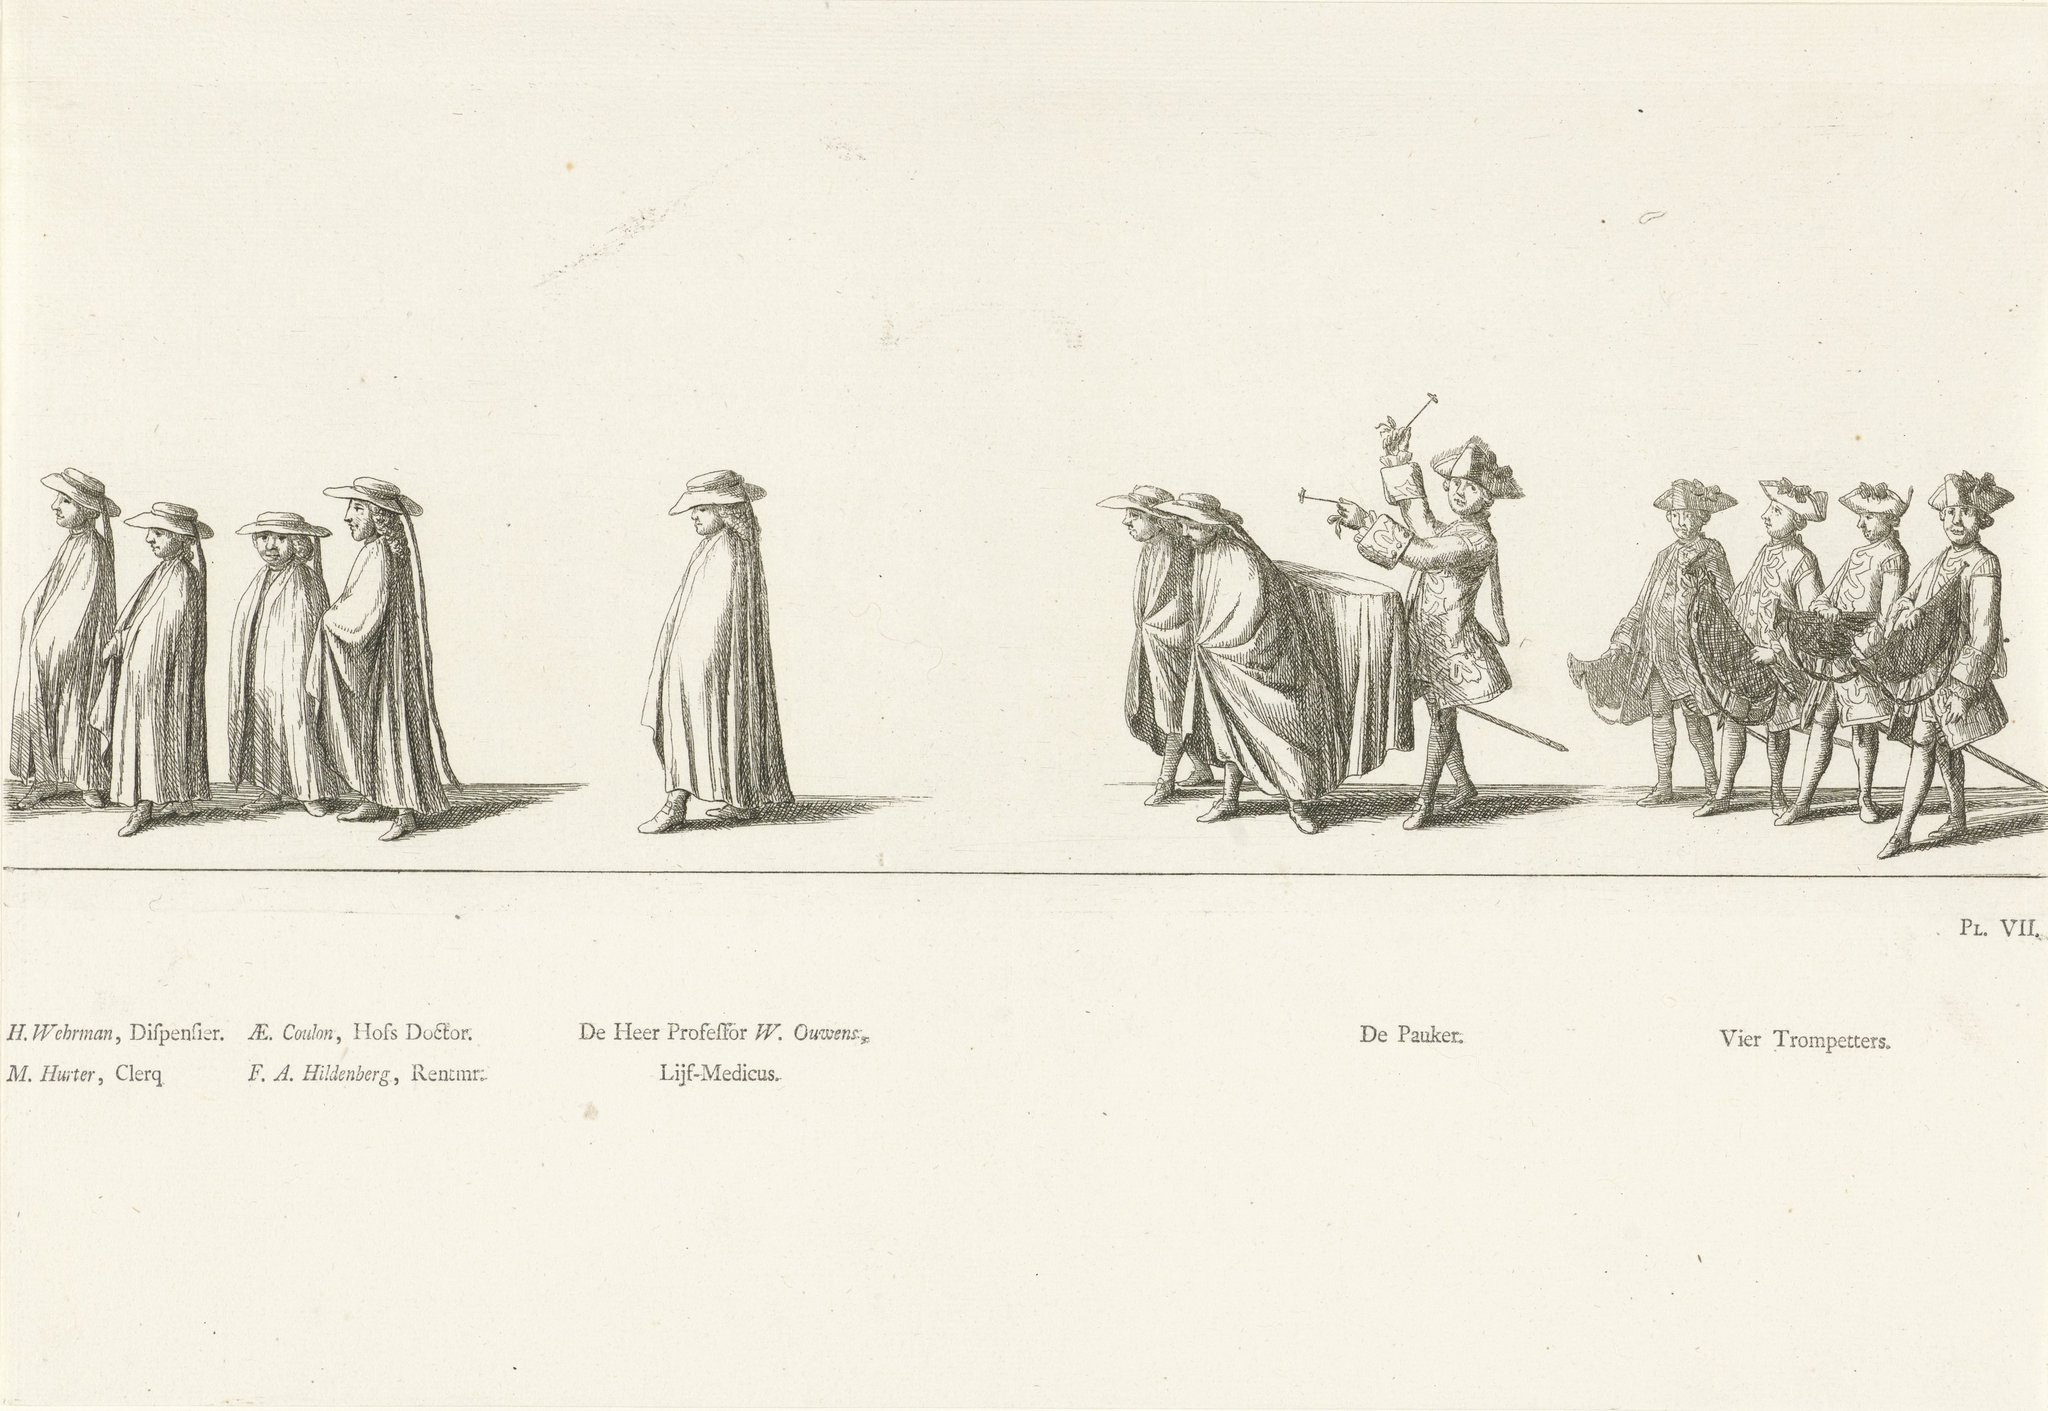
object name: print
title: Lijkstatie van prinses Maria Louise, 1765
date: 1765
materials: paper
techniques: etching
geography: leeuwarden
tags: military music, cortege, funeral procession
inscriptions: collector's mark: Lugt 2228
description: De leden van de stadhouderlijke hofhouding, een paukenier en vier trompetters. Gemerkt rechtsonder: Pl. VII. Op het blad onder de plaat de namen van personen in de stoet. Onderdeel van de serie platen van de begrafenis van prinses Maria Louise te Leeuwarden op 13 juni 1765.